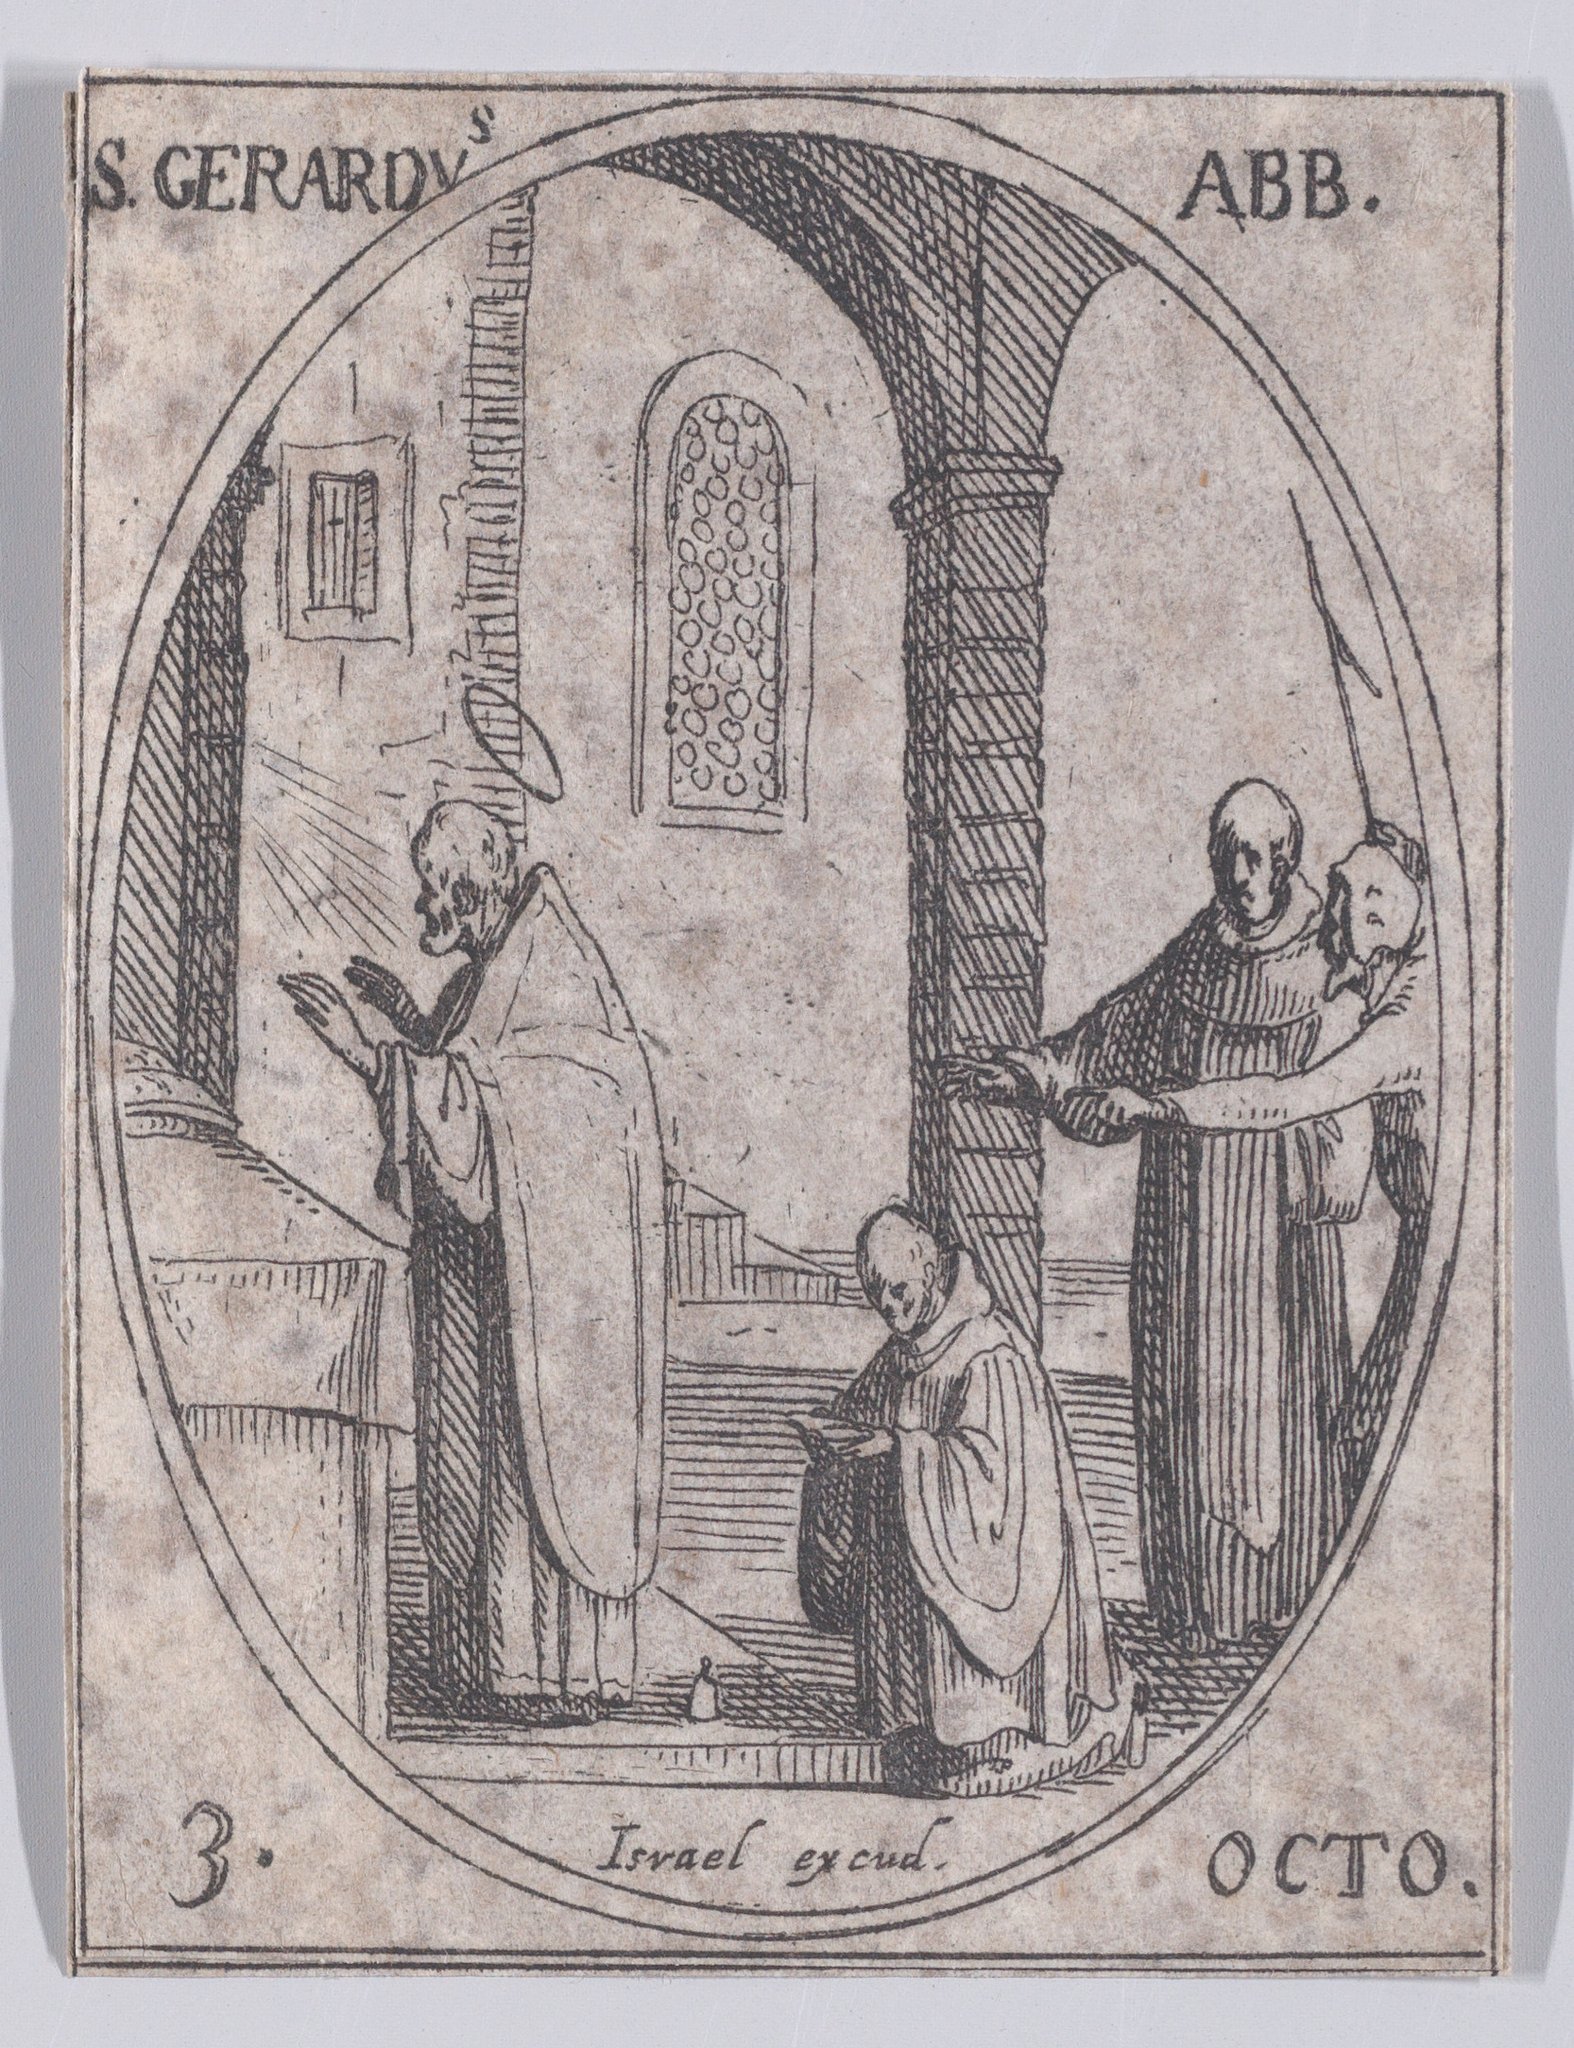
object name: print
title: S. Gérard, abbé (St. Gerard, Abbot), October 3rd, from "Les Images De Tous Les Saincts et Saintes de L'Année" (Images of All of the Saints and Religious Events of the Year)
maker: jacques callot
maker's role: artist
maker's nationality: french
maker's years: 1592-1635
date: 1636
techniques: etching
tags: men,saints